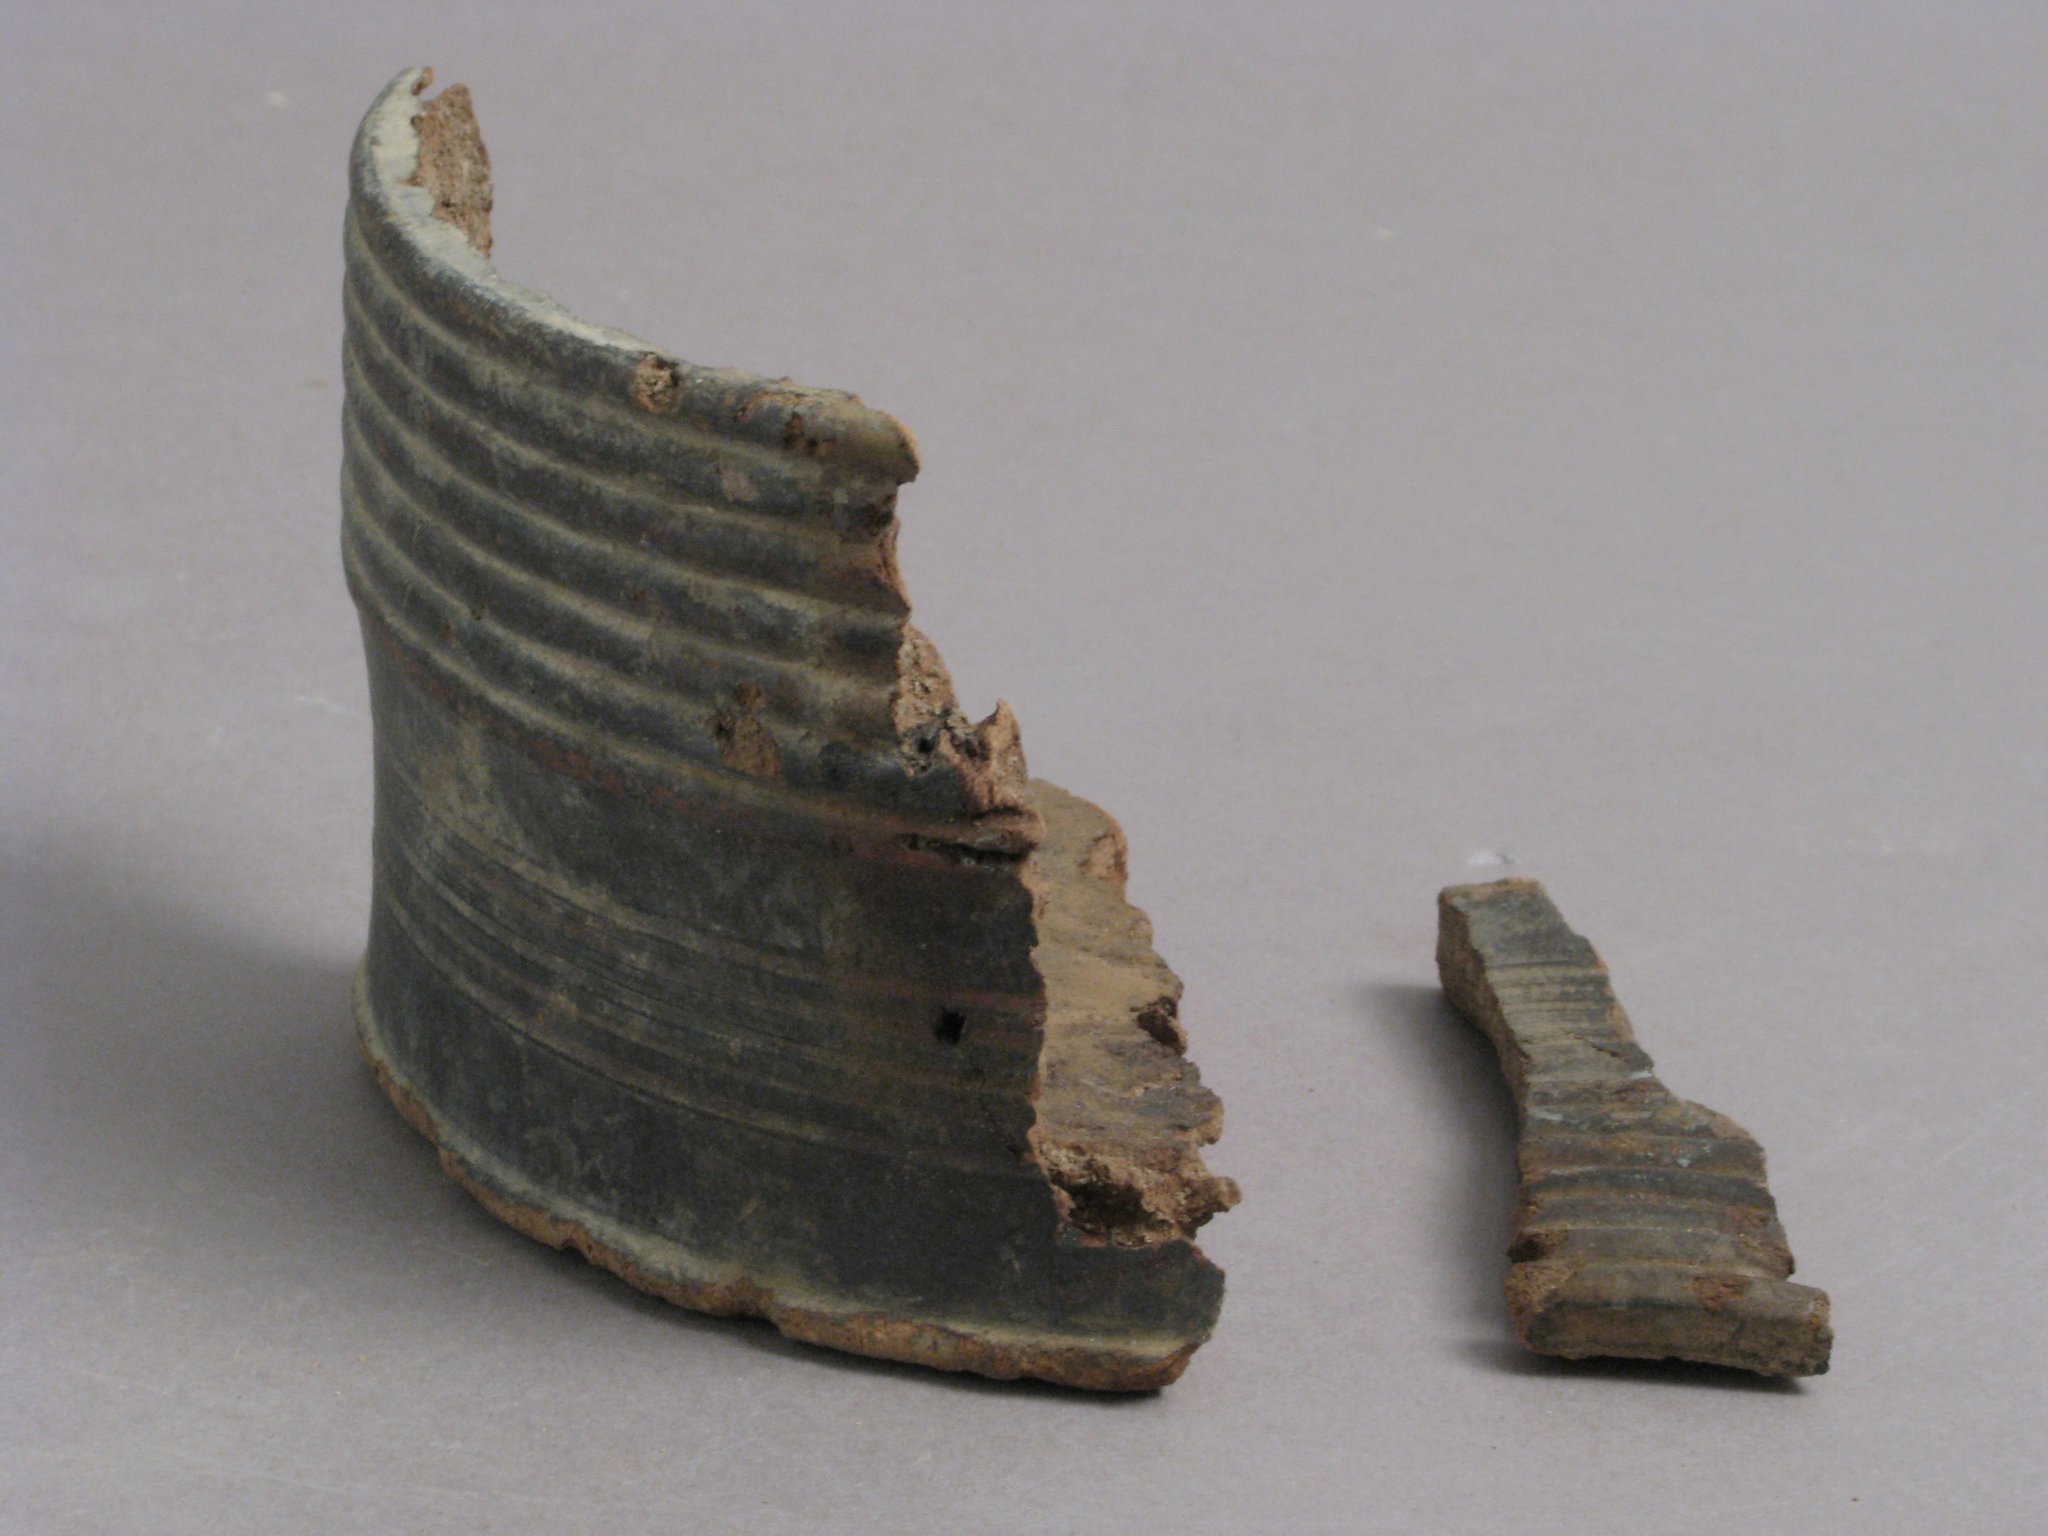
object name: fragment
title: Box Fragments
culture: coptic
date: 301-700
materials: wood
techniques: polychromy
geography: egypt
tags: boxes